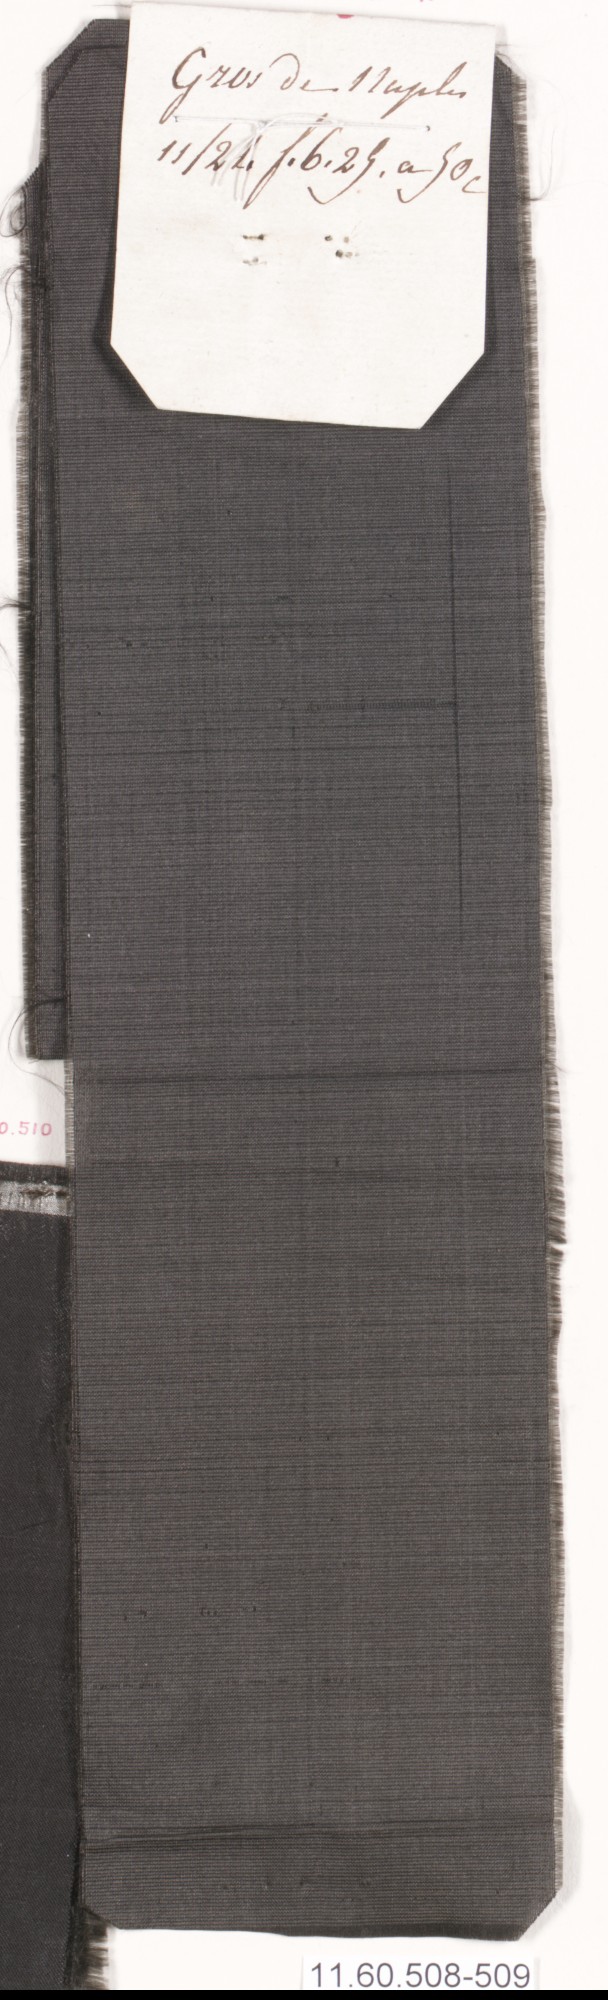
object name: sample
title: Samples (2)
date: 1801-1850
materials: silk